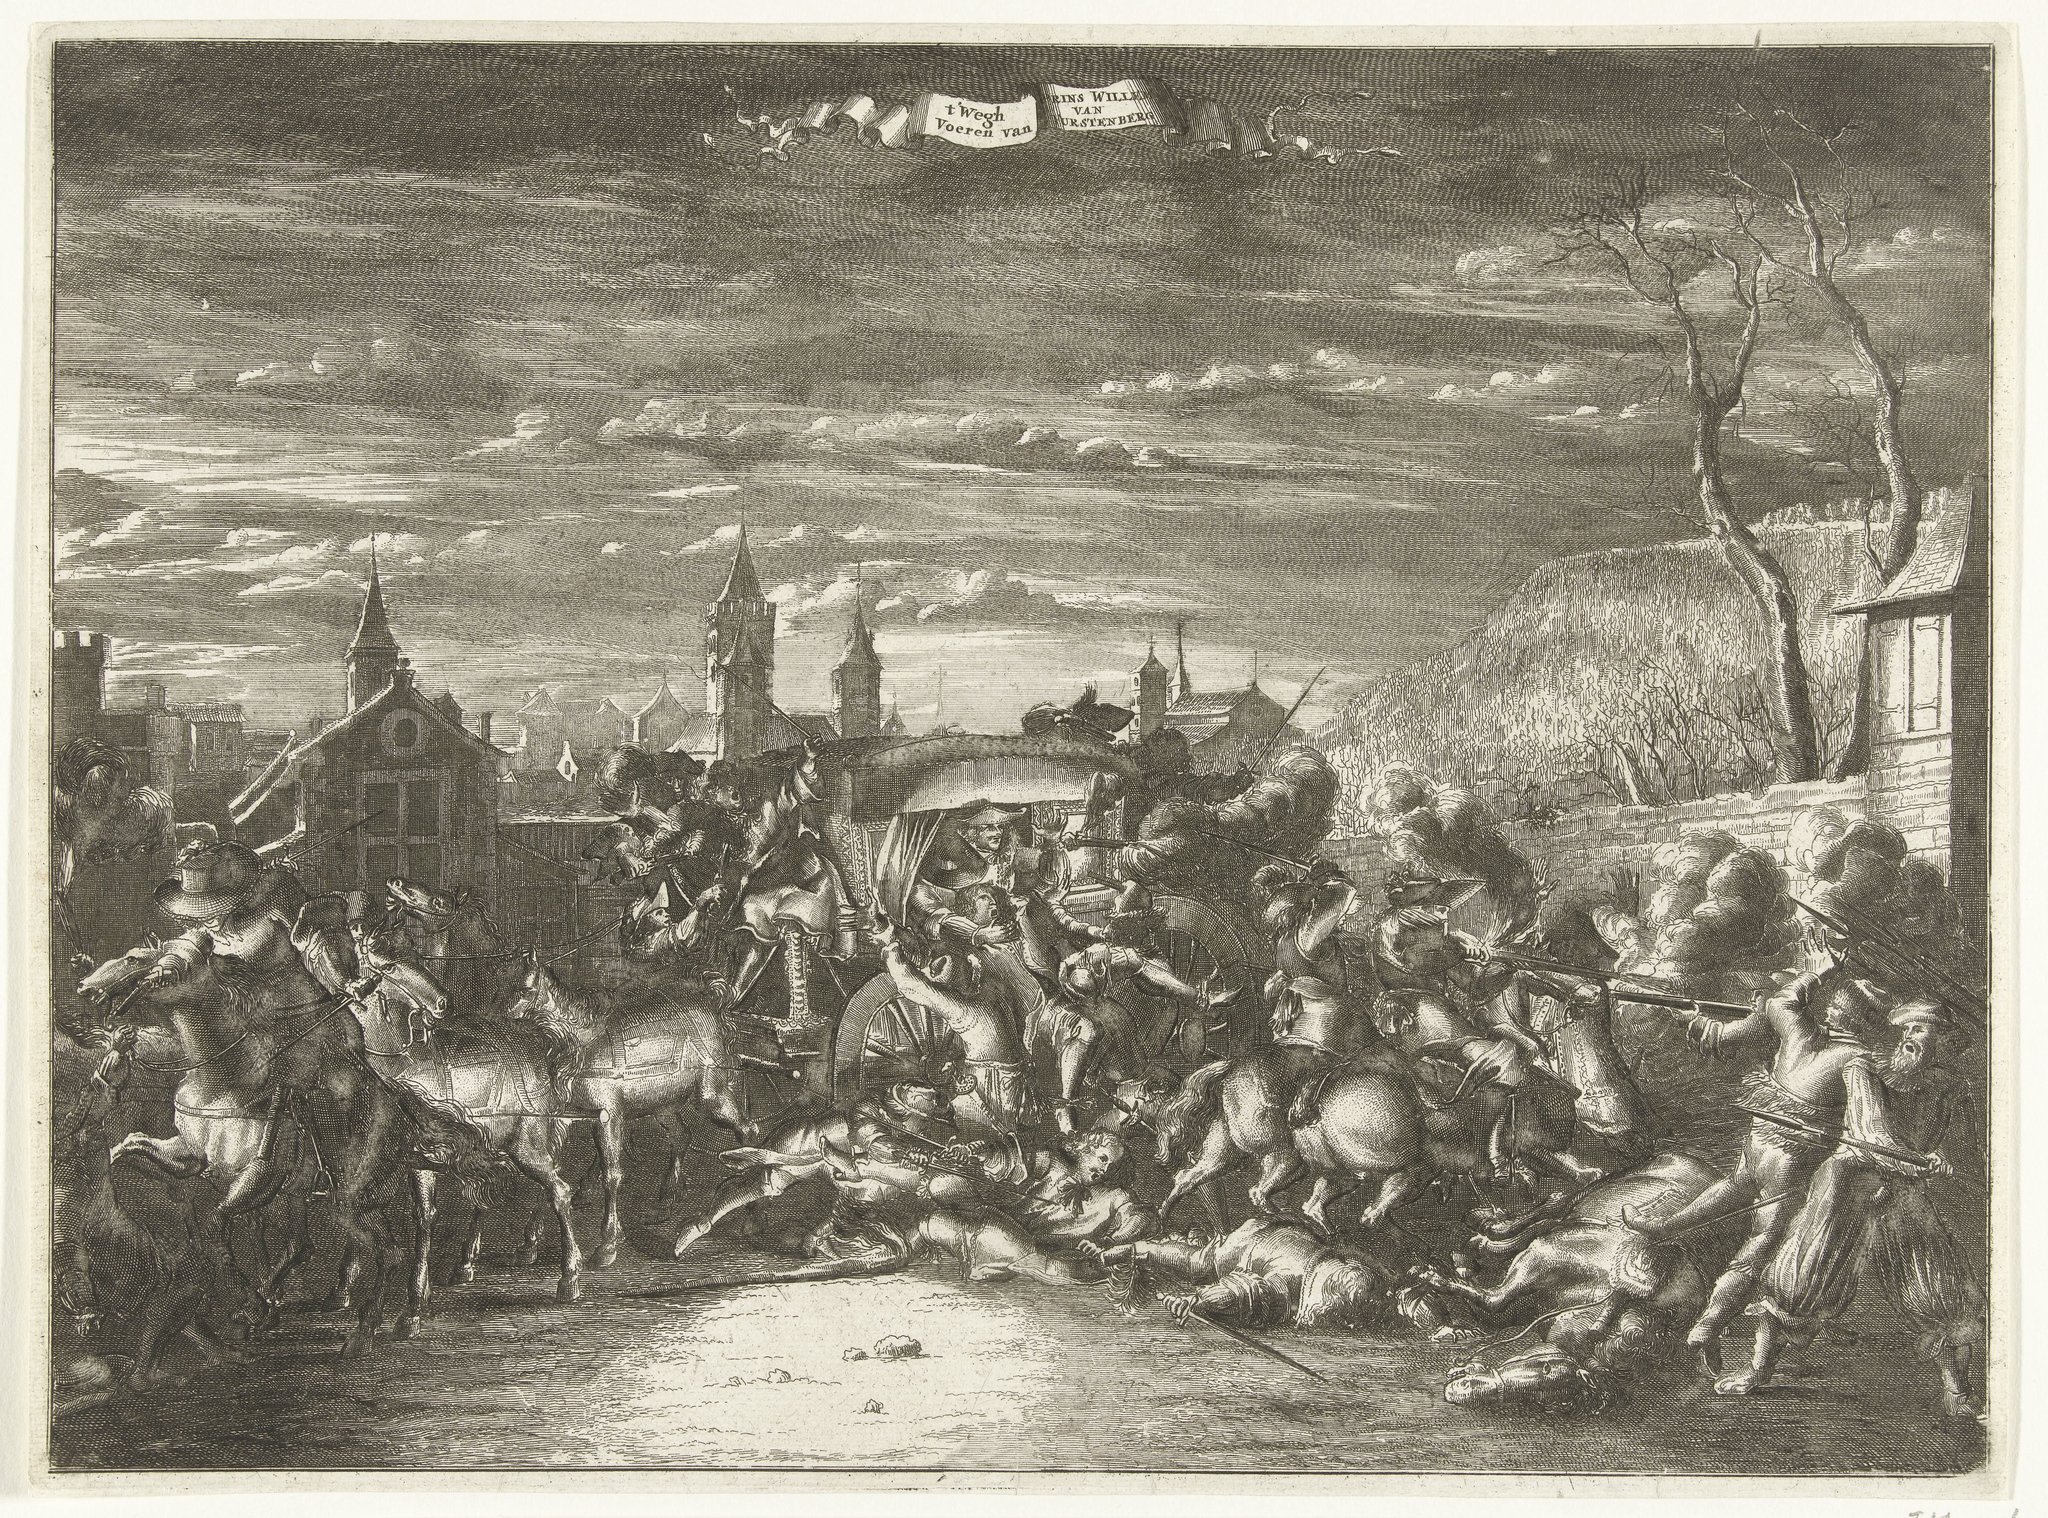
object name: print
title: Gevangenneming van prins Wilhelm von Fürstenberg, 1674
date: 1674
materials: paper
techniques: etching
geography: northern netherlands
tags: paris, abducting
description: Gevangenneming en ontvoering van prins Wilhelm von Fürstenberg, 16 februari 1674. In de nacht wordt de prins overvallen en in een rijtuig meegenomen.